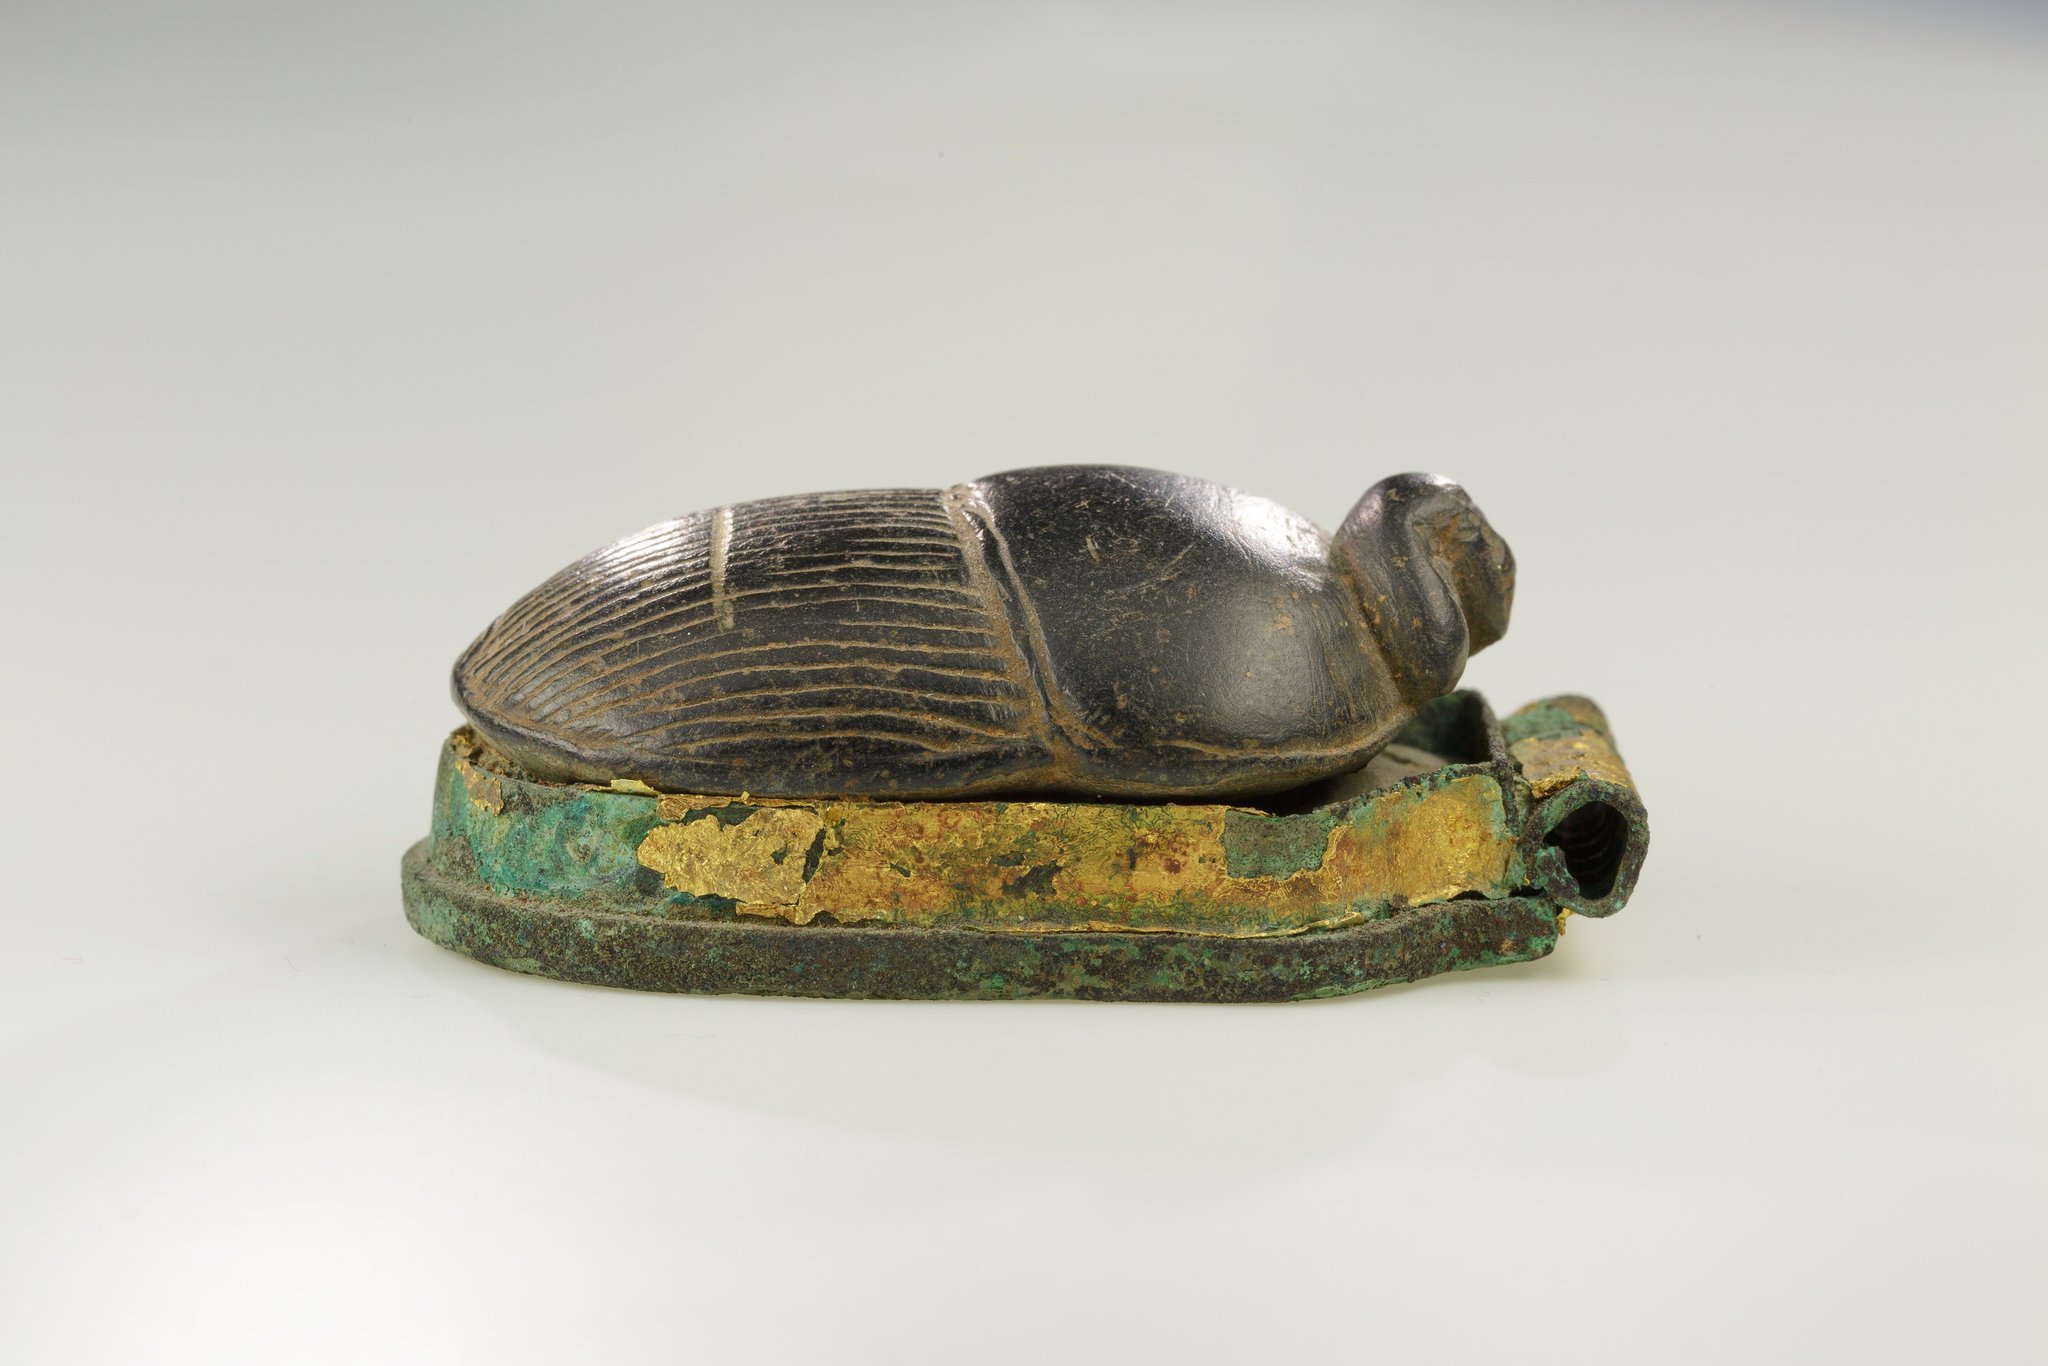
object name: scarab, heart, human head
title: Heart Scarab with a Human Head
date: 1550-1070 BCE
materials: stone, bronze, gold leaf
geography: egypt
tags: hieroglyphs,scarabs